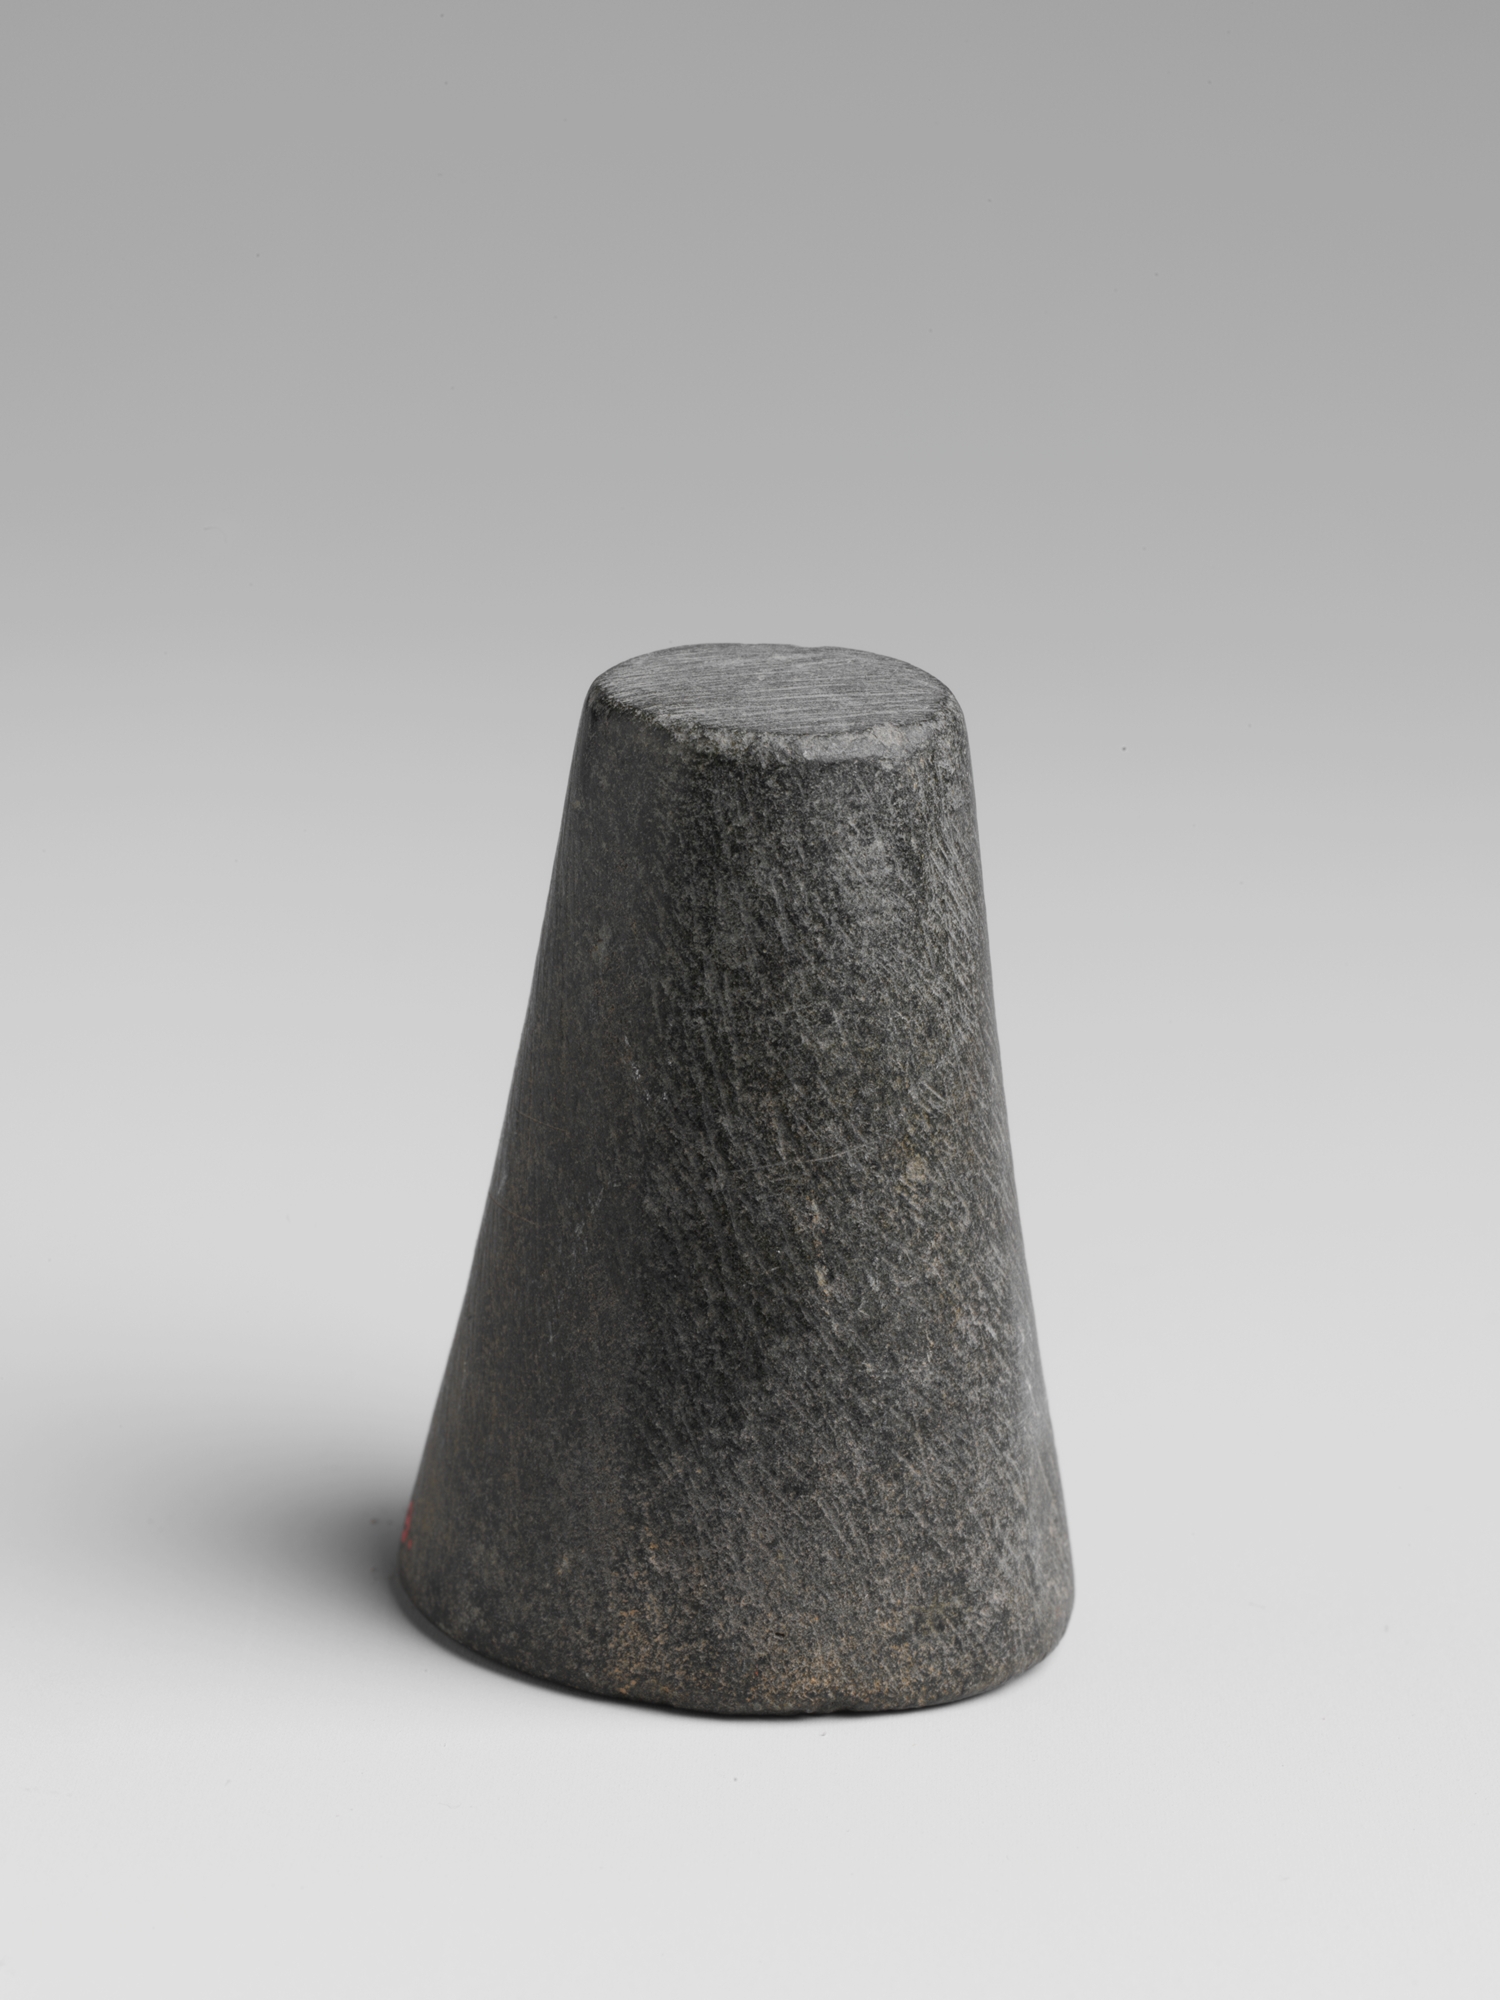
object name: pestle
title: Chlorite pestle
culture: cypriot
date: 1600-1100 BCE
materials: mineral